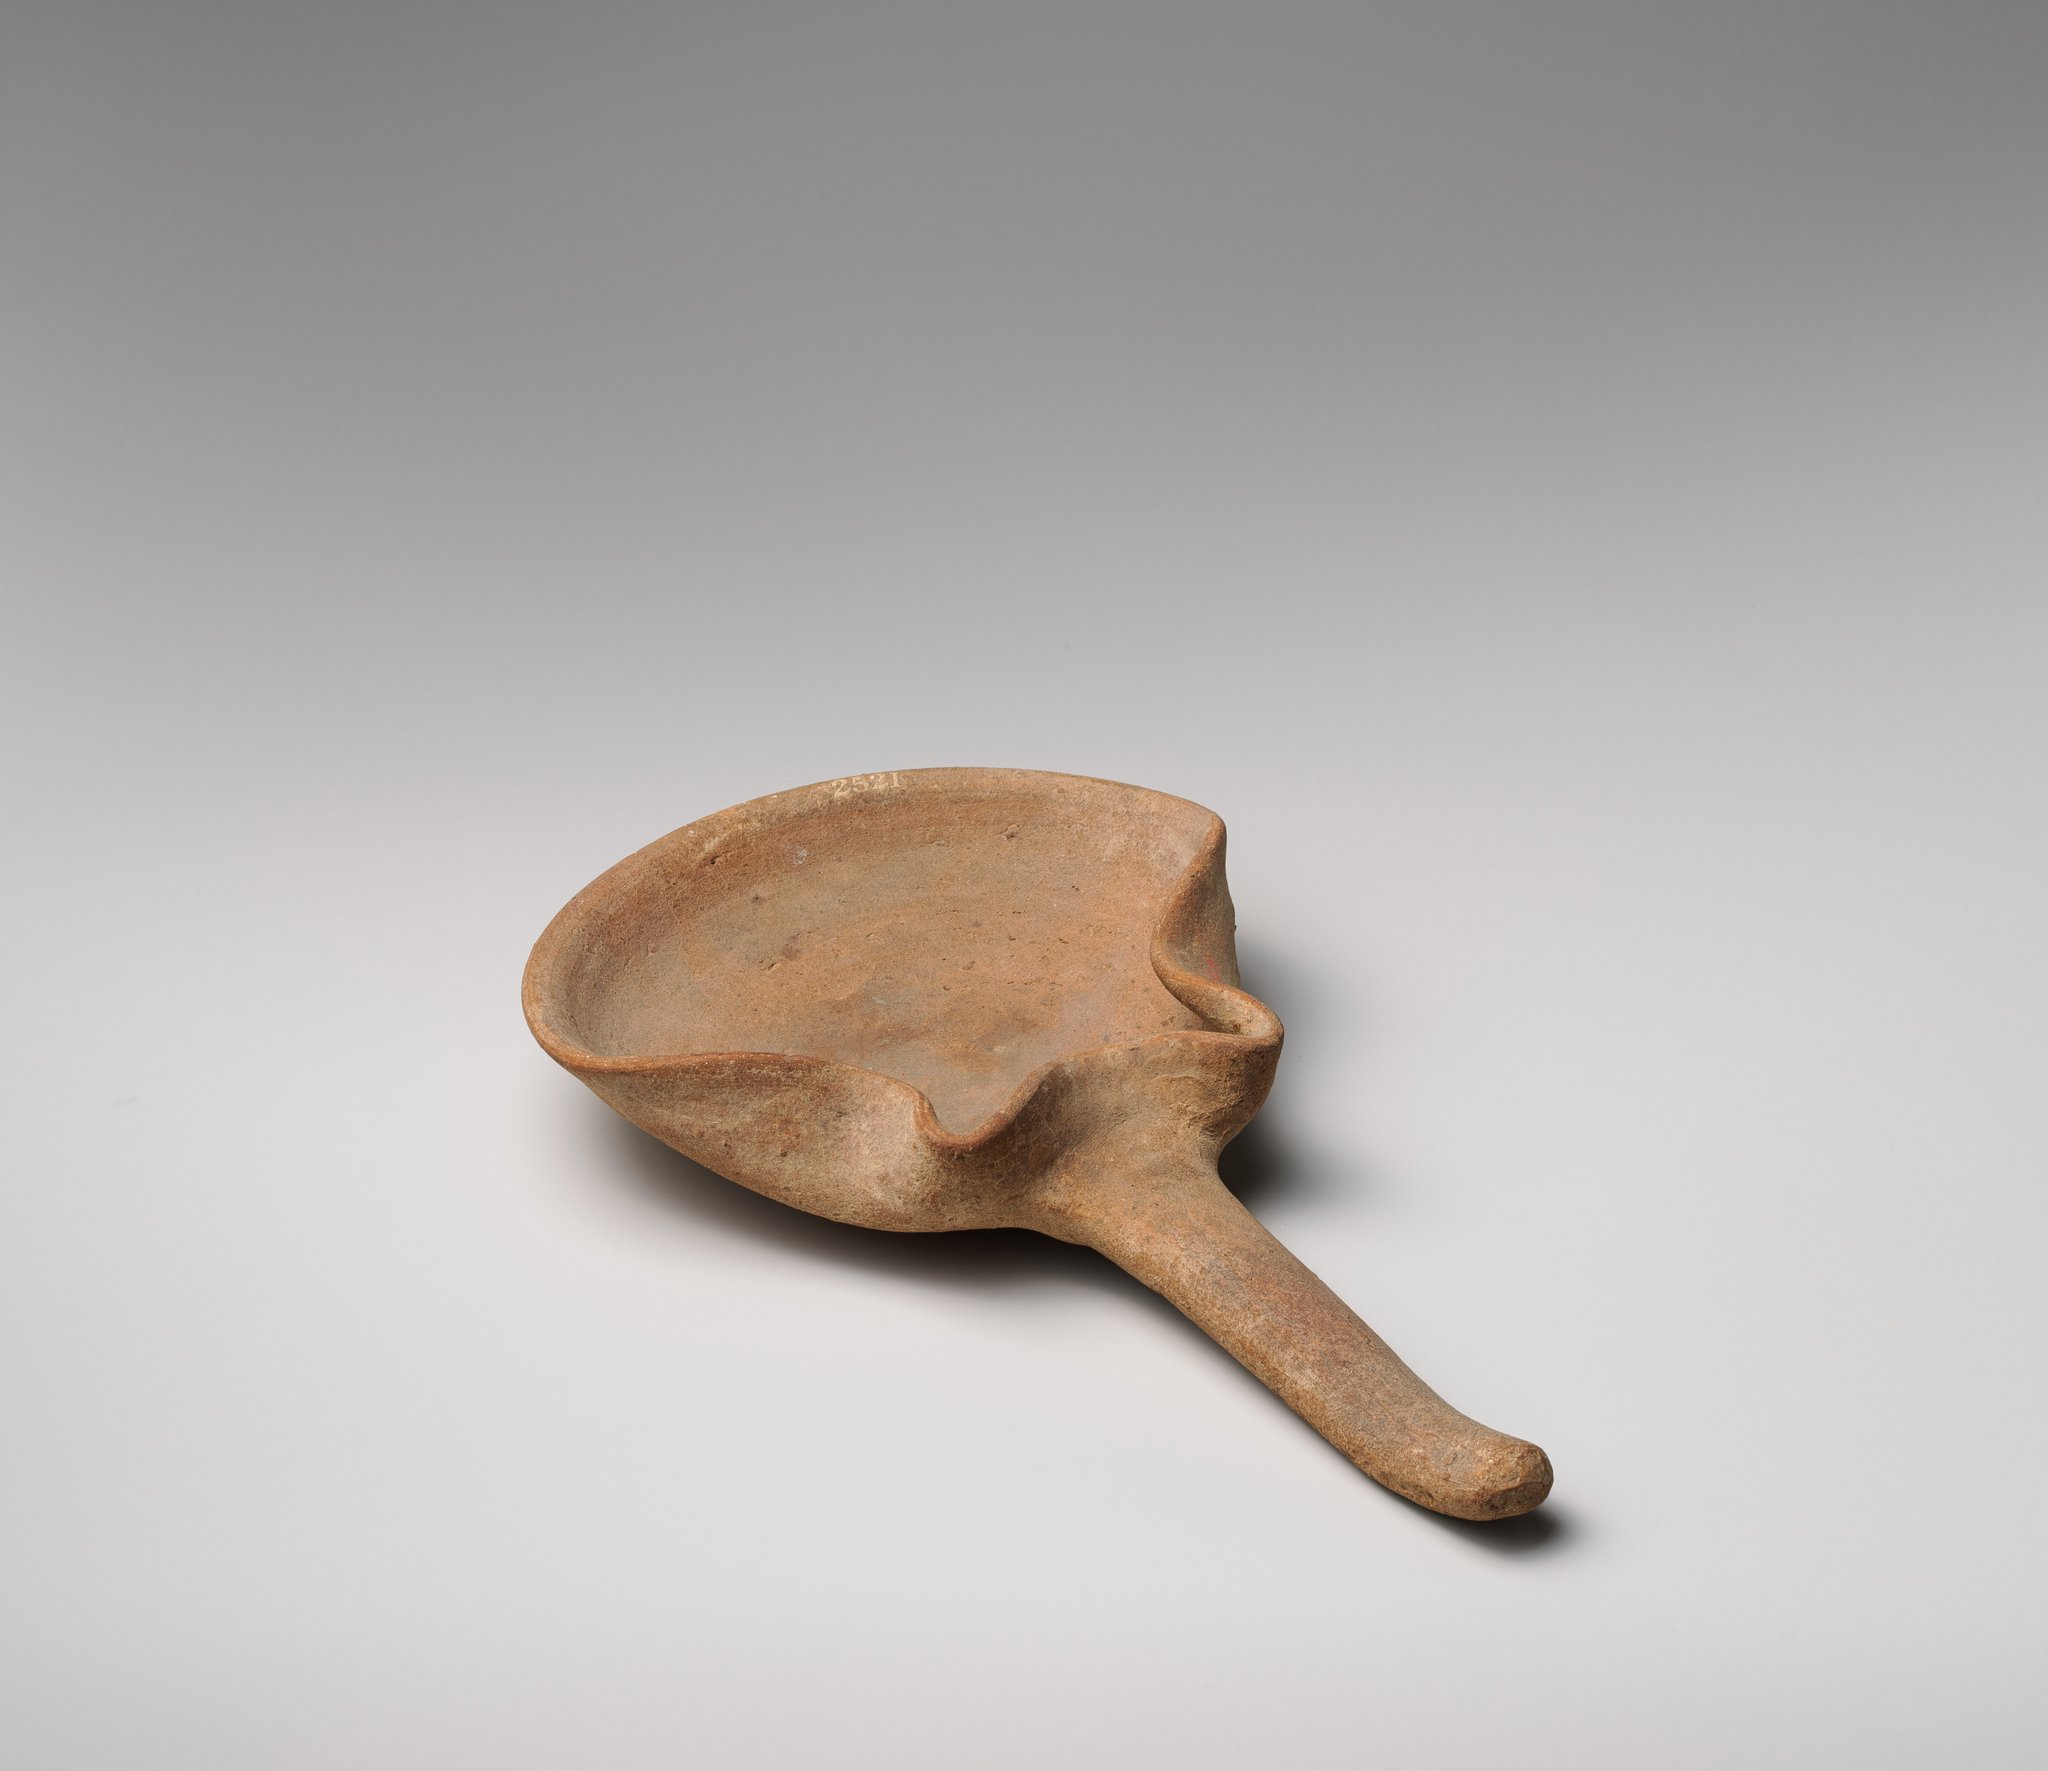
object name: lamp, saucer, handled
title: Terracotta handled saucer-shaped oil lamp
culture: cypriot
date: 400-301 BCE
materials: terracotta